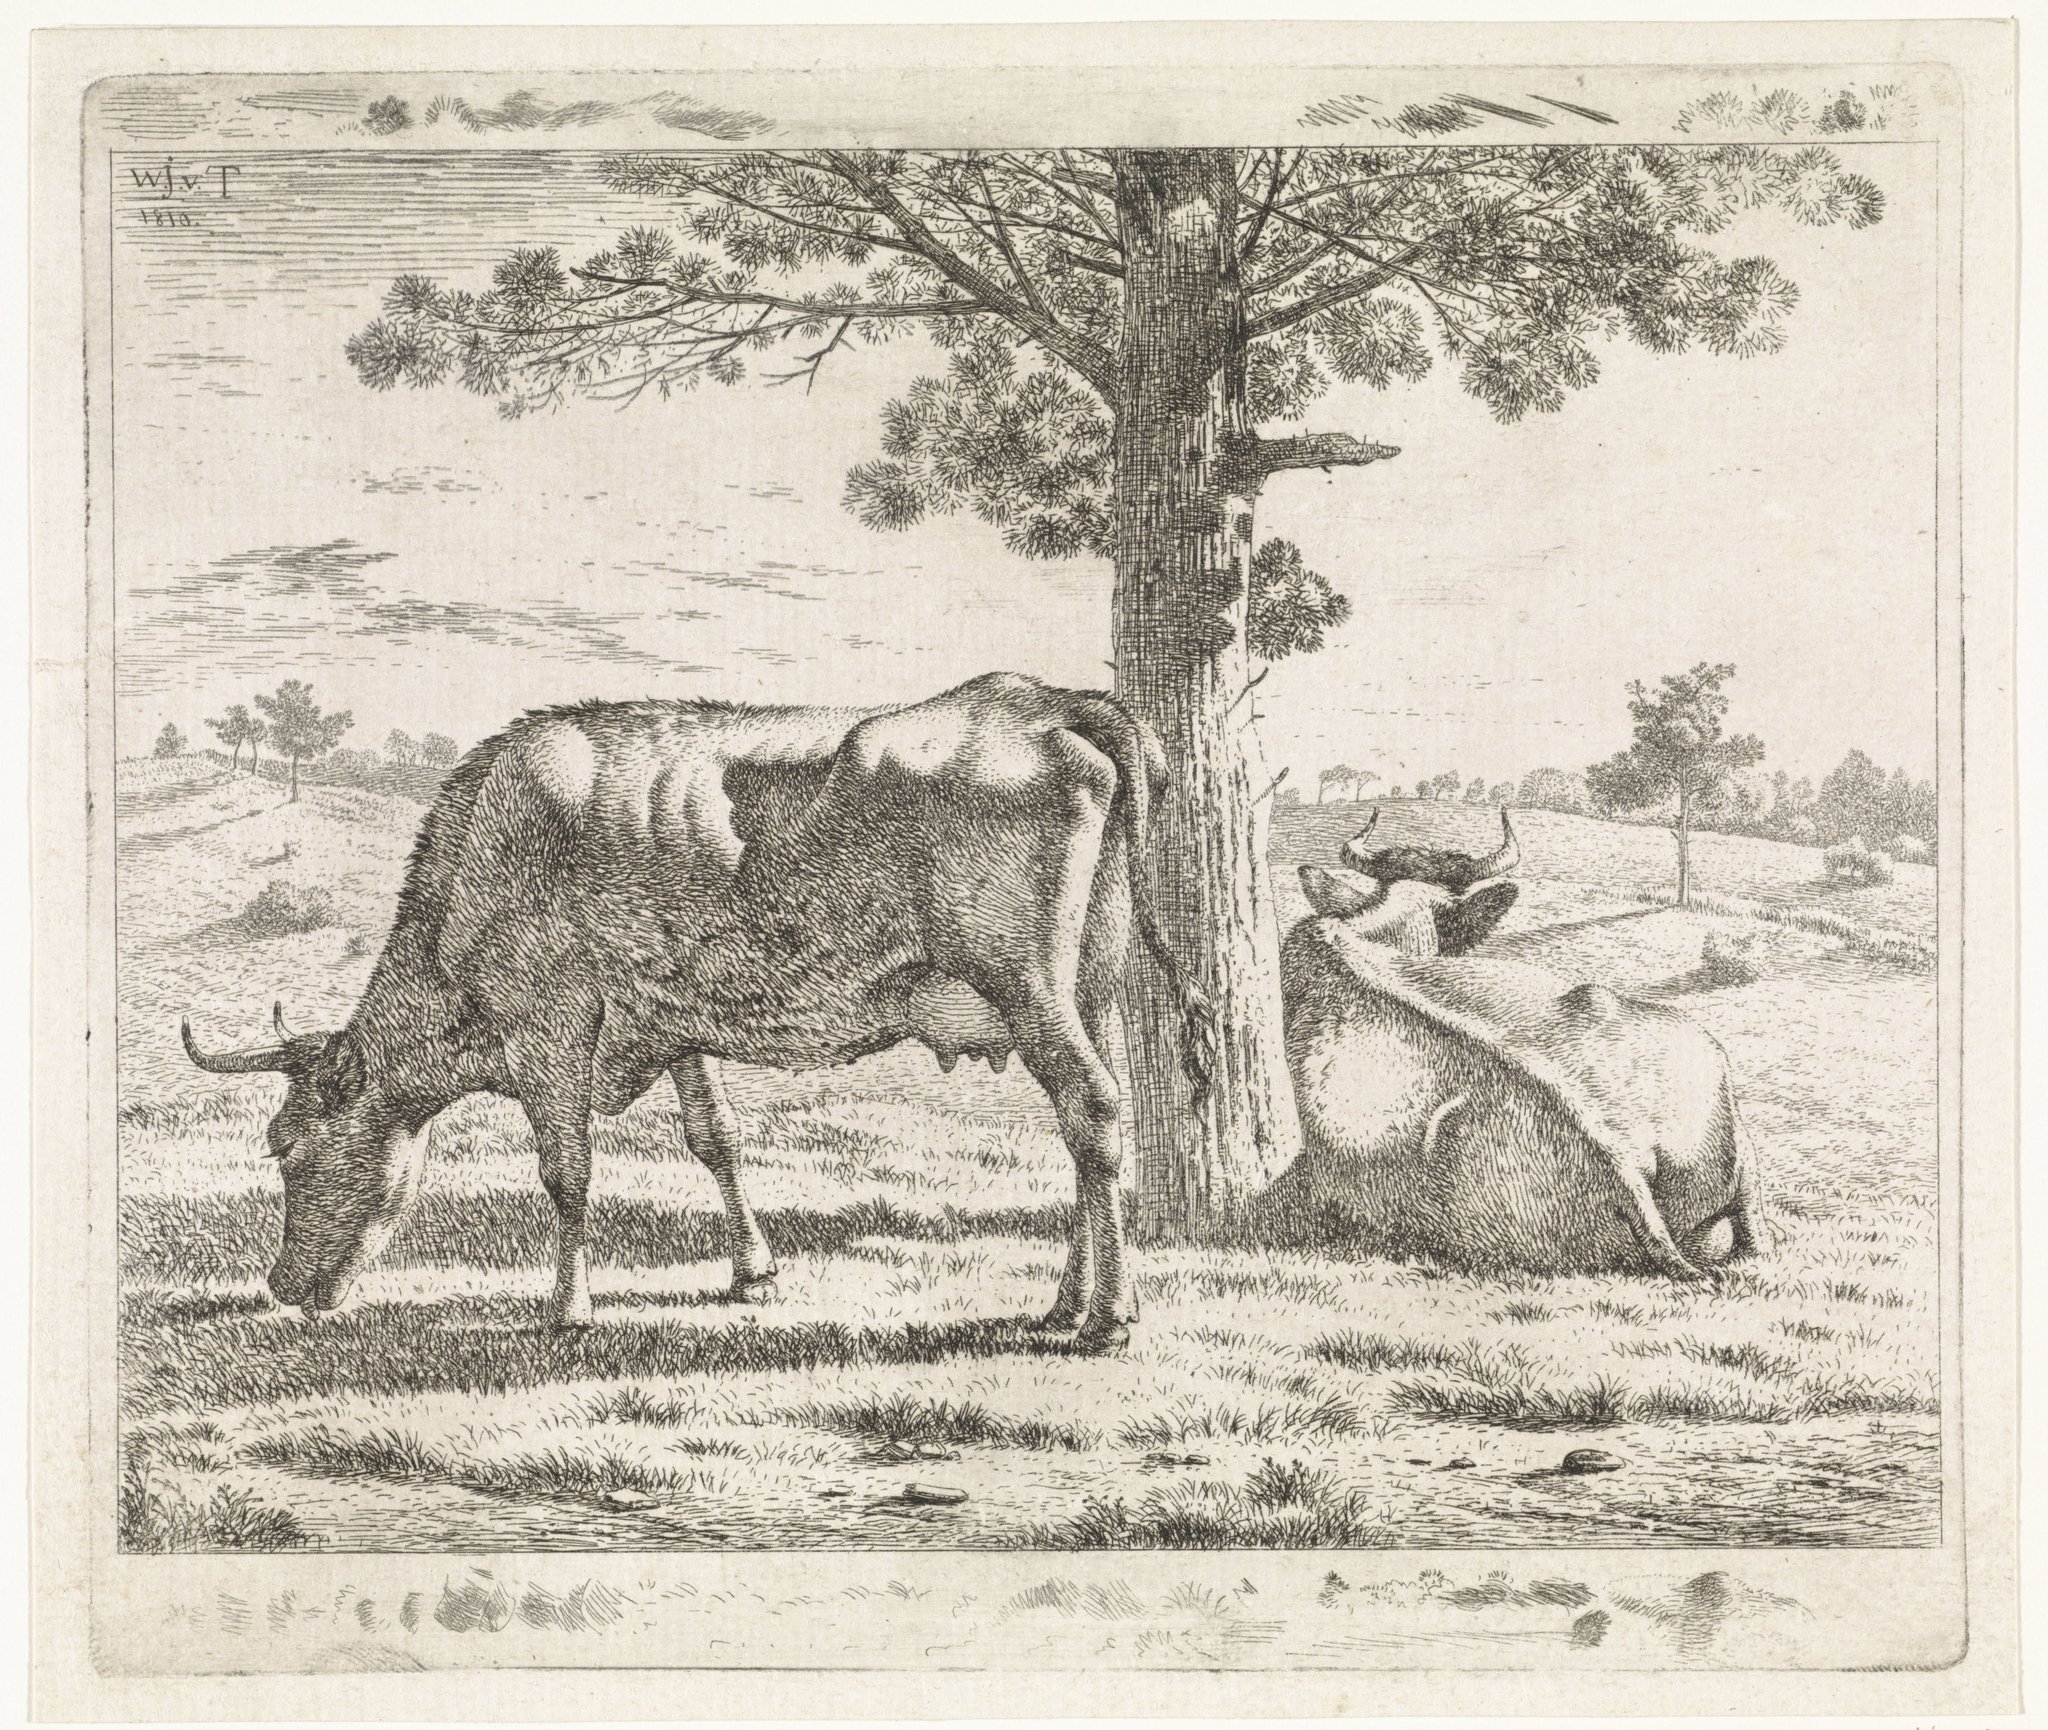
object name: print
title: Twee koeien bij een boom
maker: wouter johannes van troostwijk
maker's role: draughtsman, painter, print maker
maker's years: 1782-1810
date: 1810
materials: paper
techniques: etching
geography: amsterdam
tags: cow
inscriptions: collector's mark: Lugt 2228